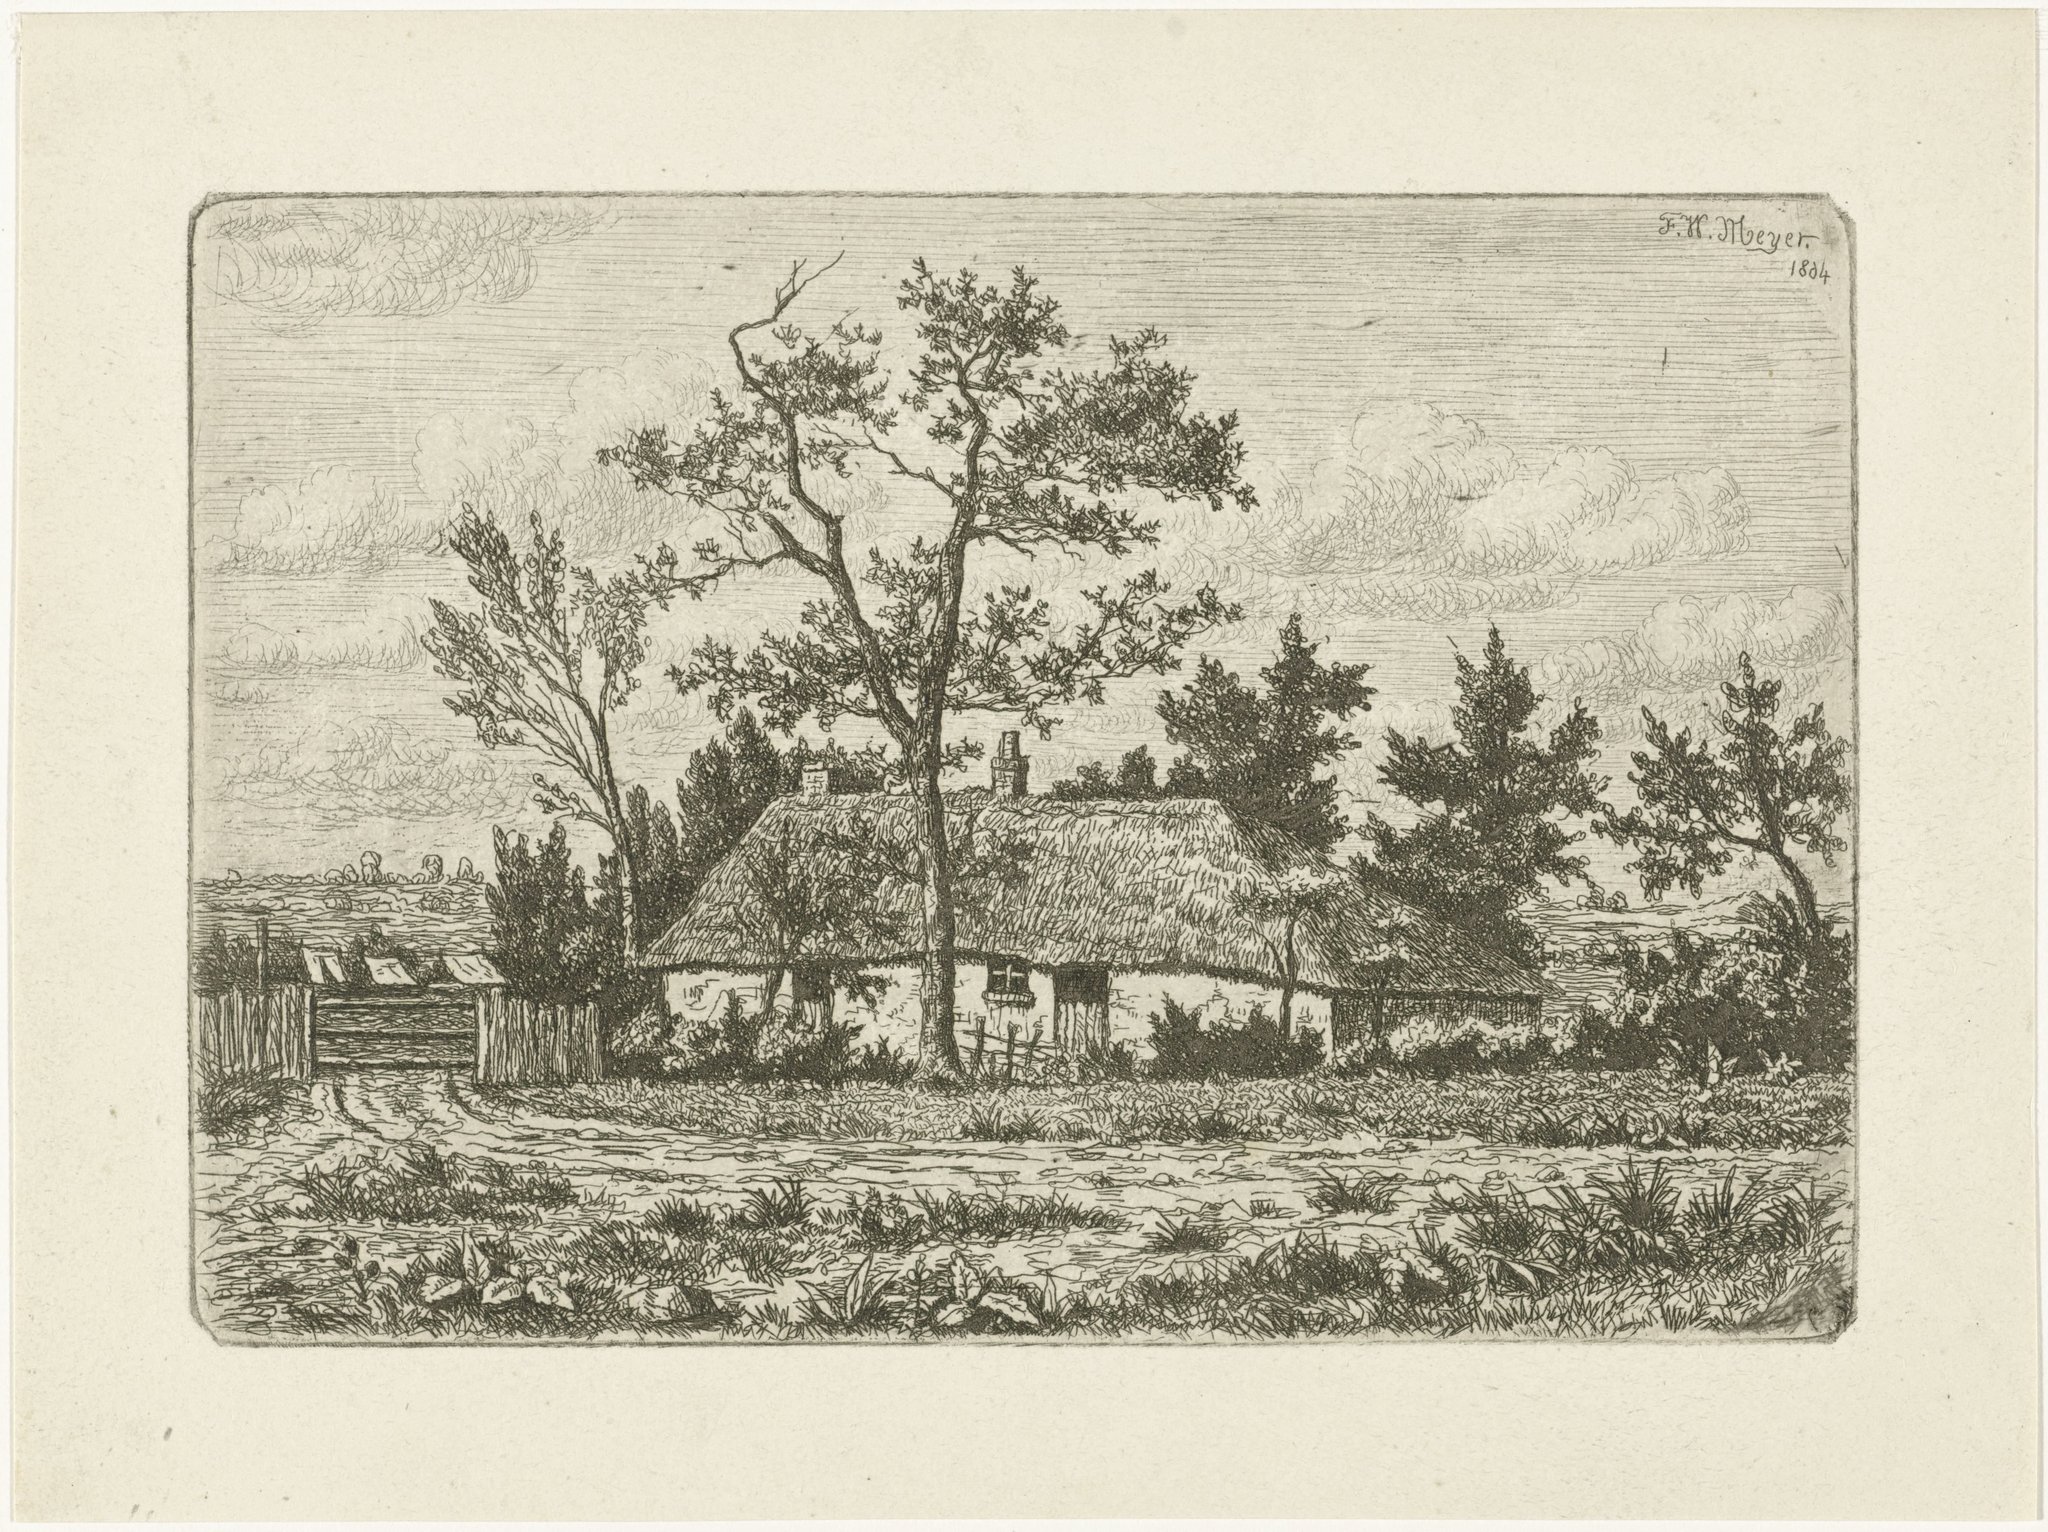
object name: print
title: Hofstede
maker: f.w. meyer (graveur)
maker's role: print maker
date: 1864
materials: paper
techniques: etching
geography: netherlands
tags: farm or solitary house in landscape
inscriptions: collector's mark: Lugt 2228